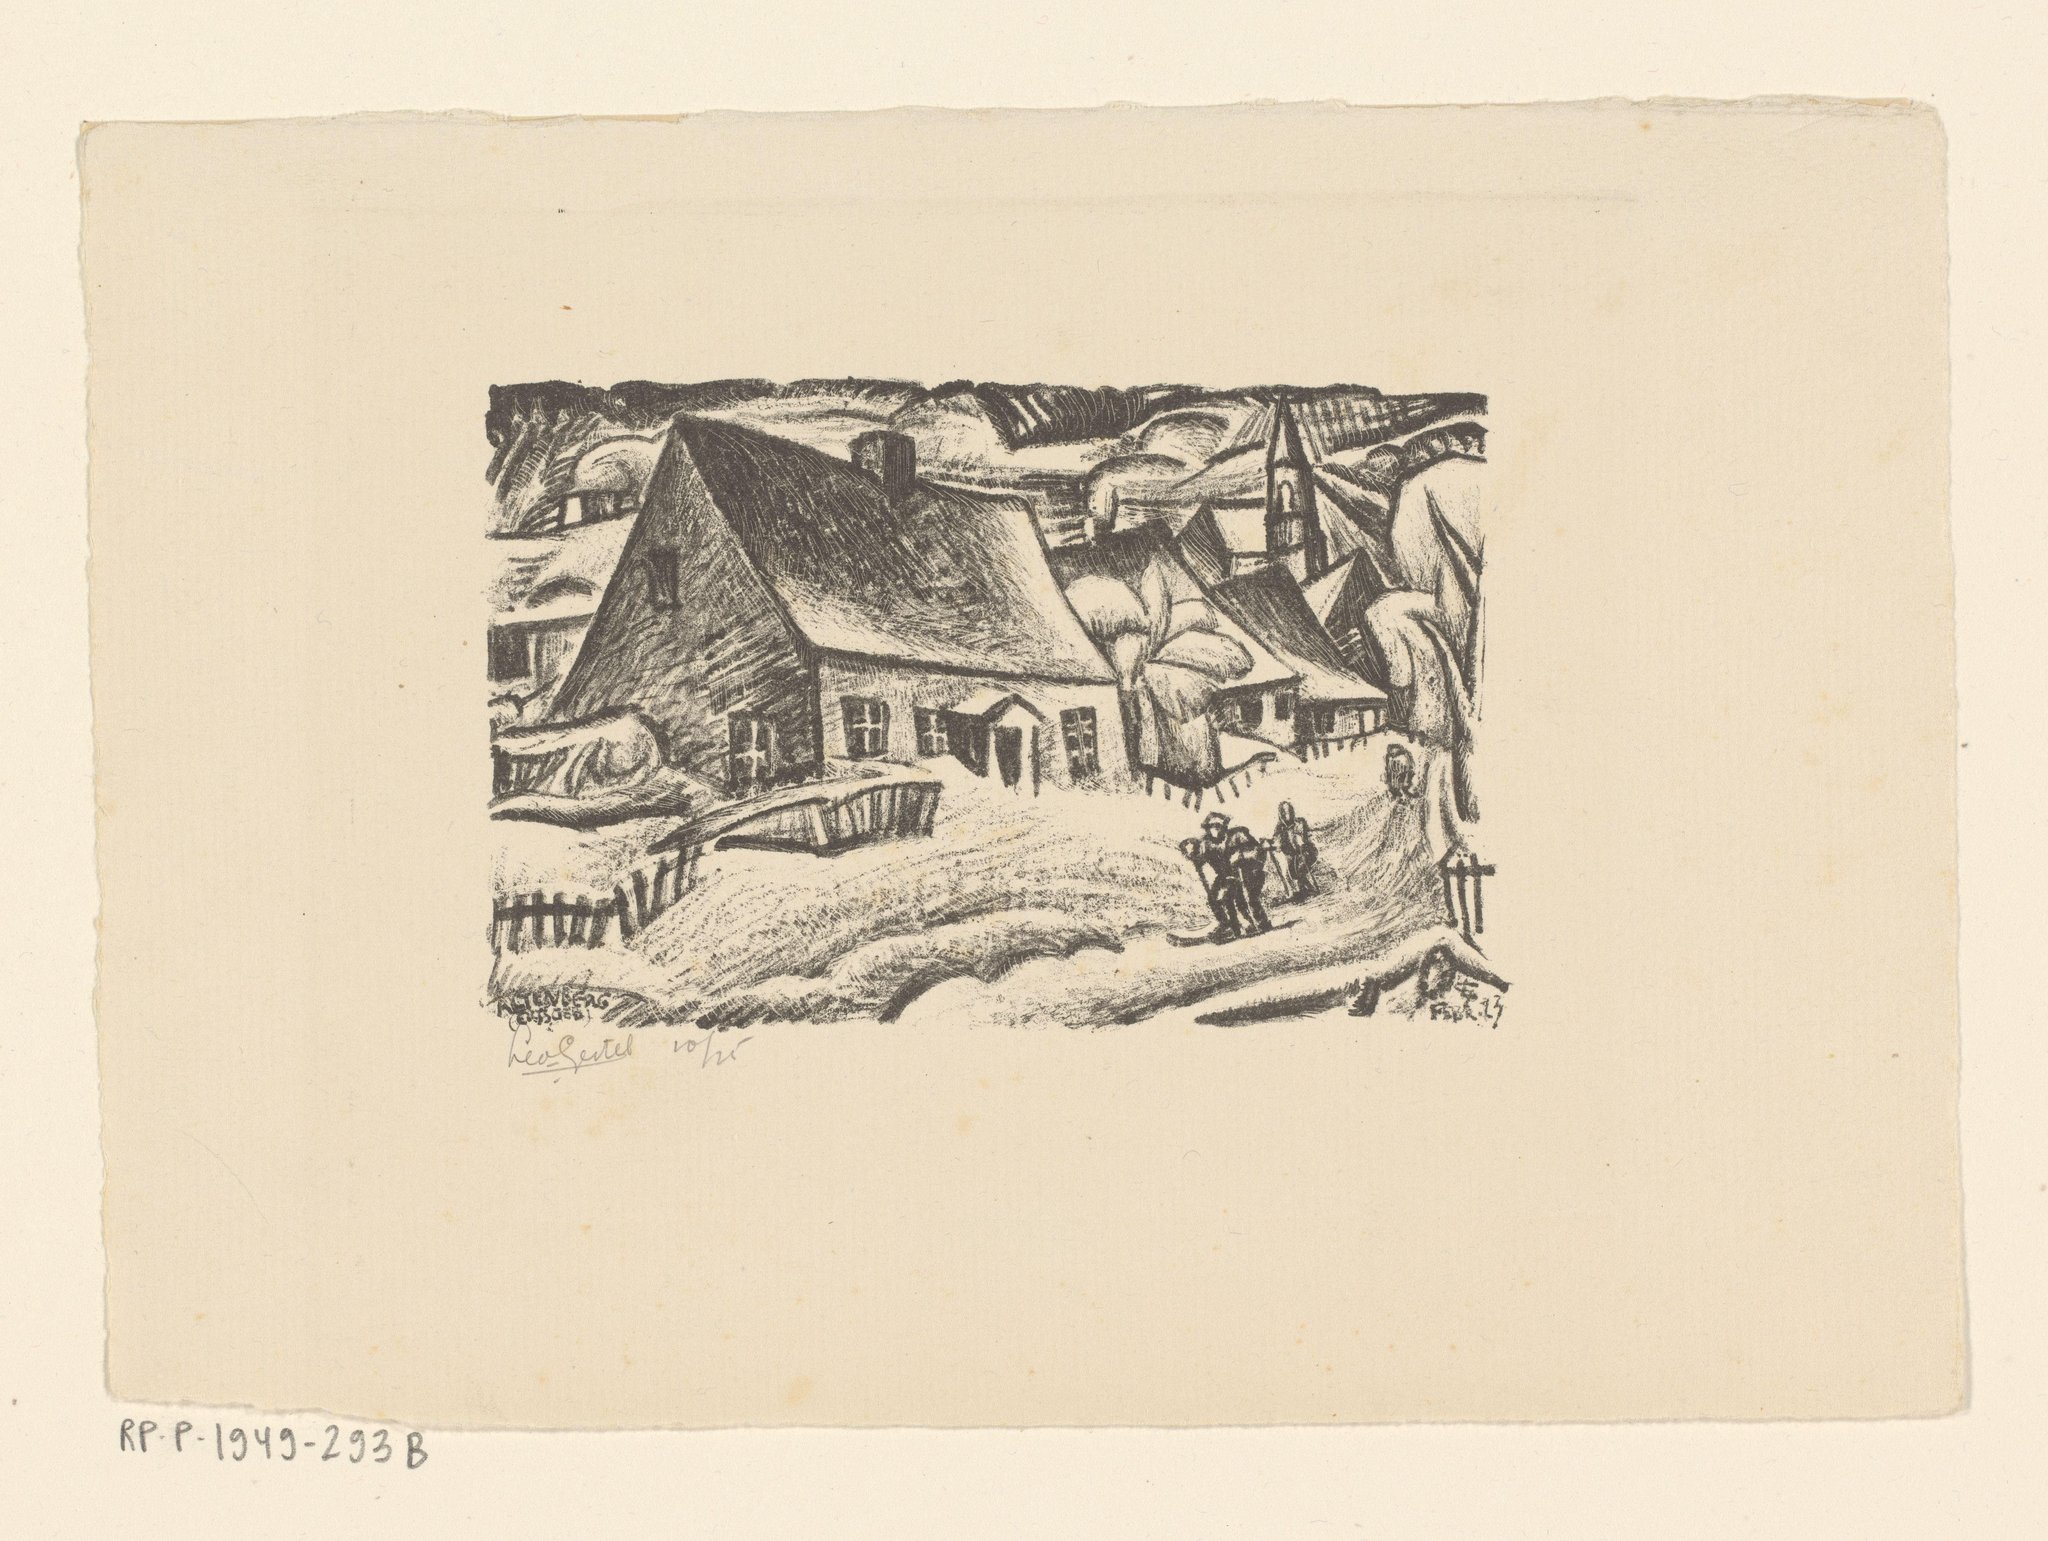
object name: print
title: Altenberg (Ertsgebergte)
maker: leo gestel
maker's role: draughtsman, print maker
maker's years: 1881-1941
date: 1902-1923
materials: paper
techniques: lithograph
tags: skis (winter sports), earth, world as celestial body, snow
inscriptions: collector's mark: Lugt 2228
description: Het besneeuwde dorp Altenberg in het Duitse Saksen. Op straat twee langlaufende figuren.